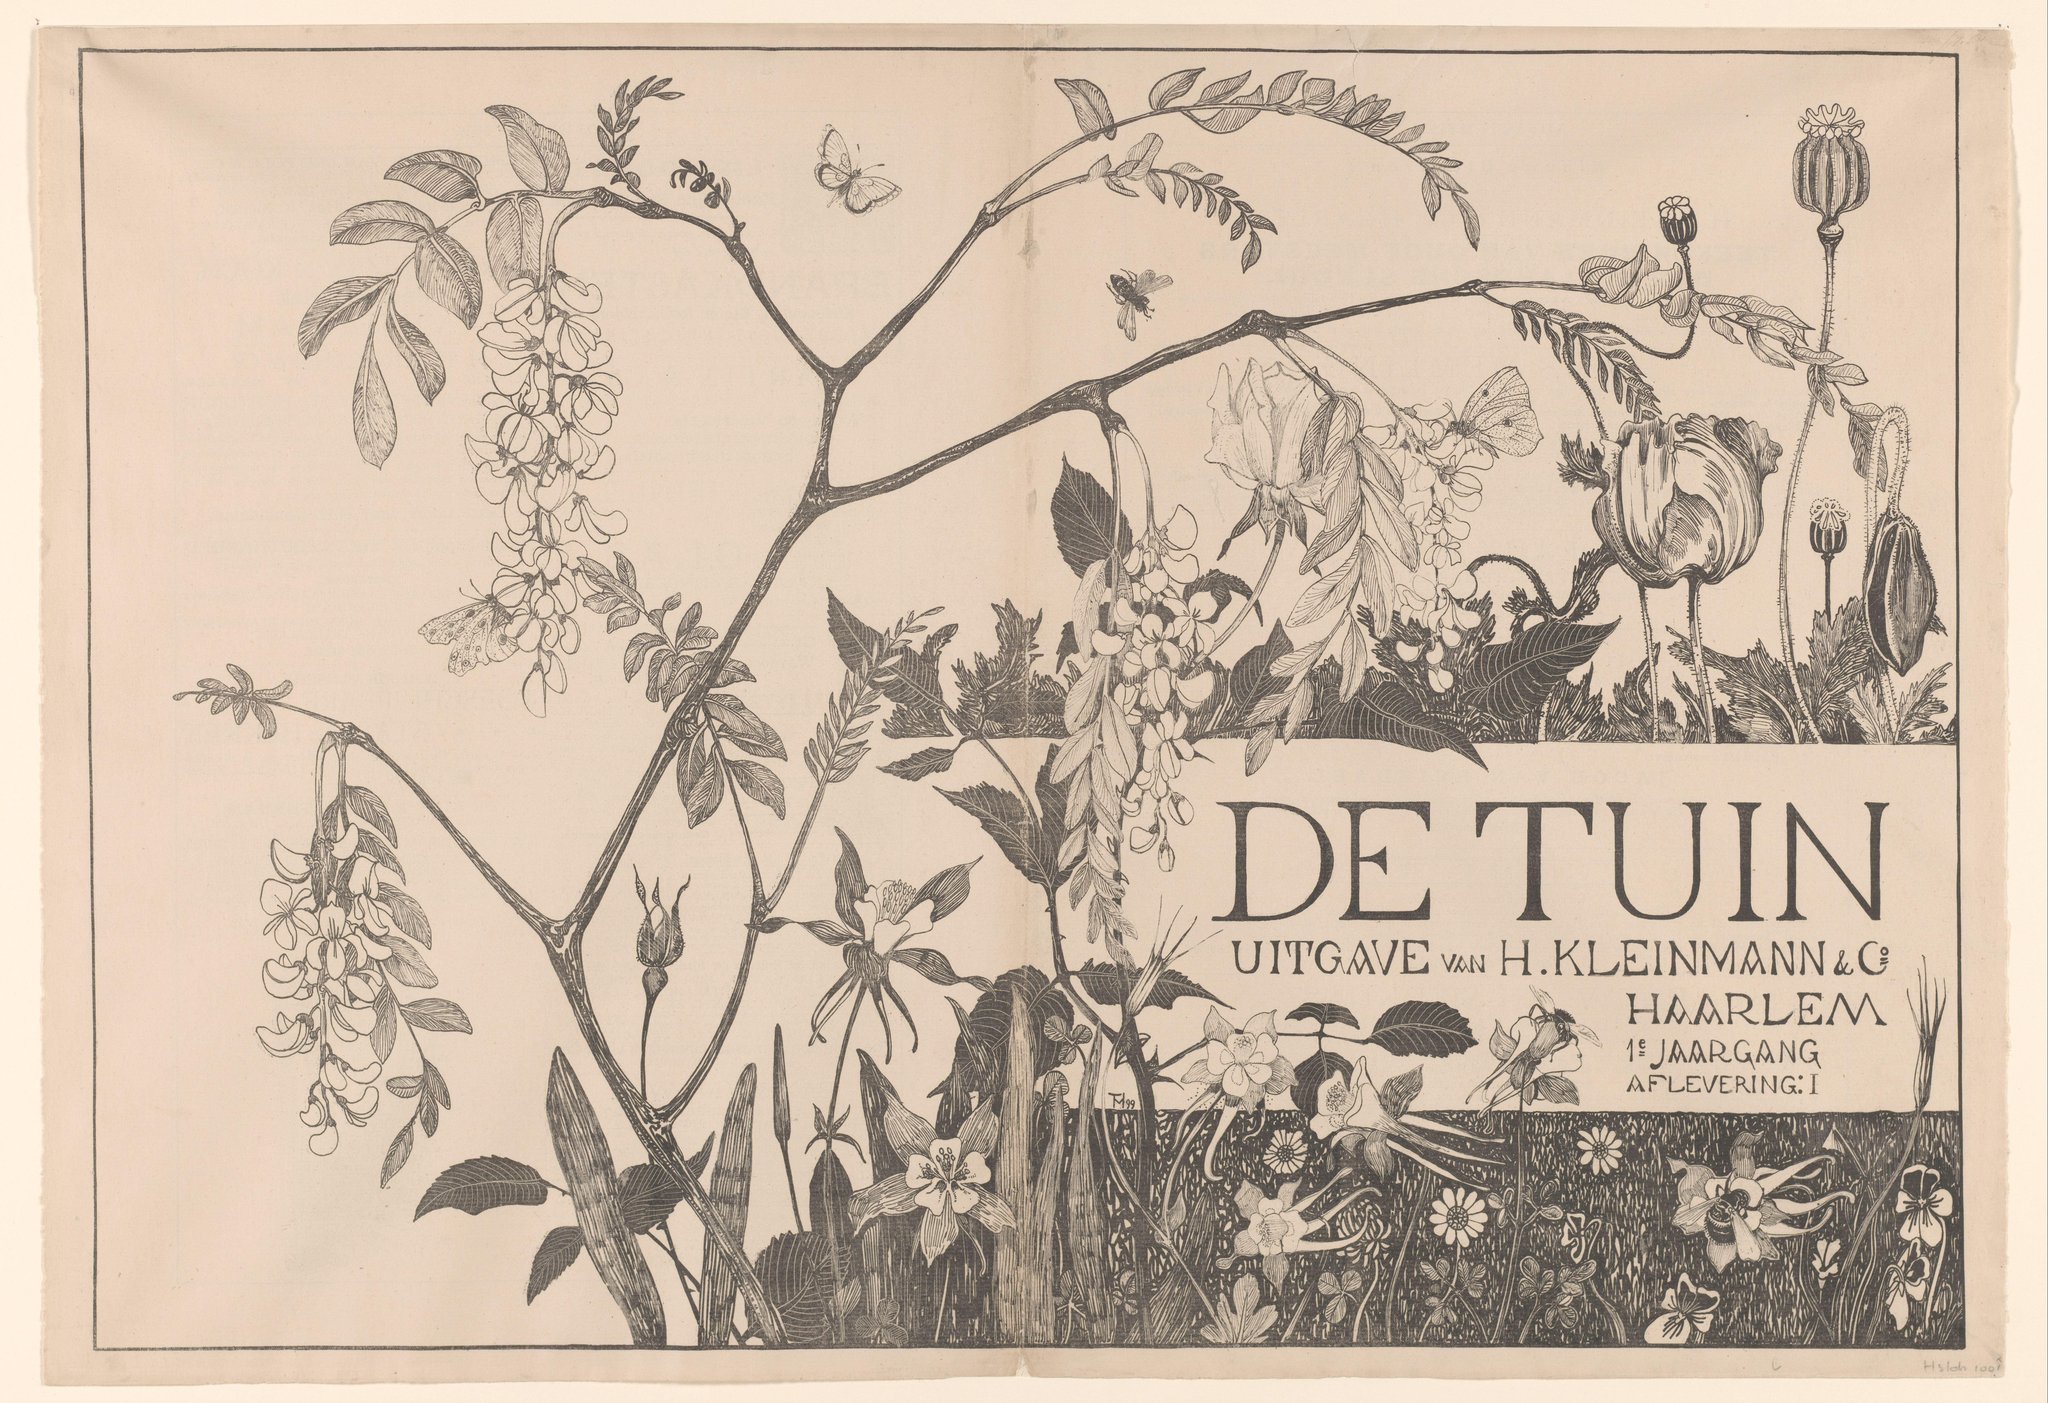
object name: wrapper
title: Omslag voor het tijdschrift 'De Tuin'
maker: theo van hoytema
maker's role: draughtsman, painter, print maker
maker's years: 1863-1917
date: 1899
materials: paper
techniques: lithograph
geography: haarlem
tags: flowers, garden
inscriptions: collector's mark: Lugt 2233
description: Omslag voor het eerste nummer van de eerste jaargang.